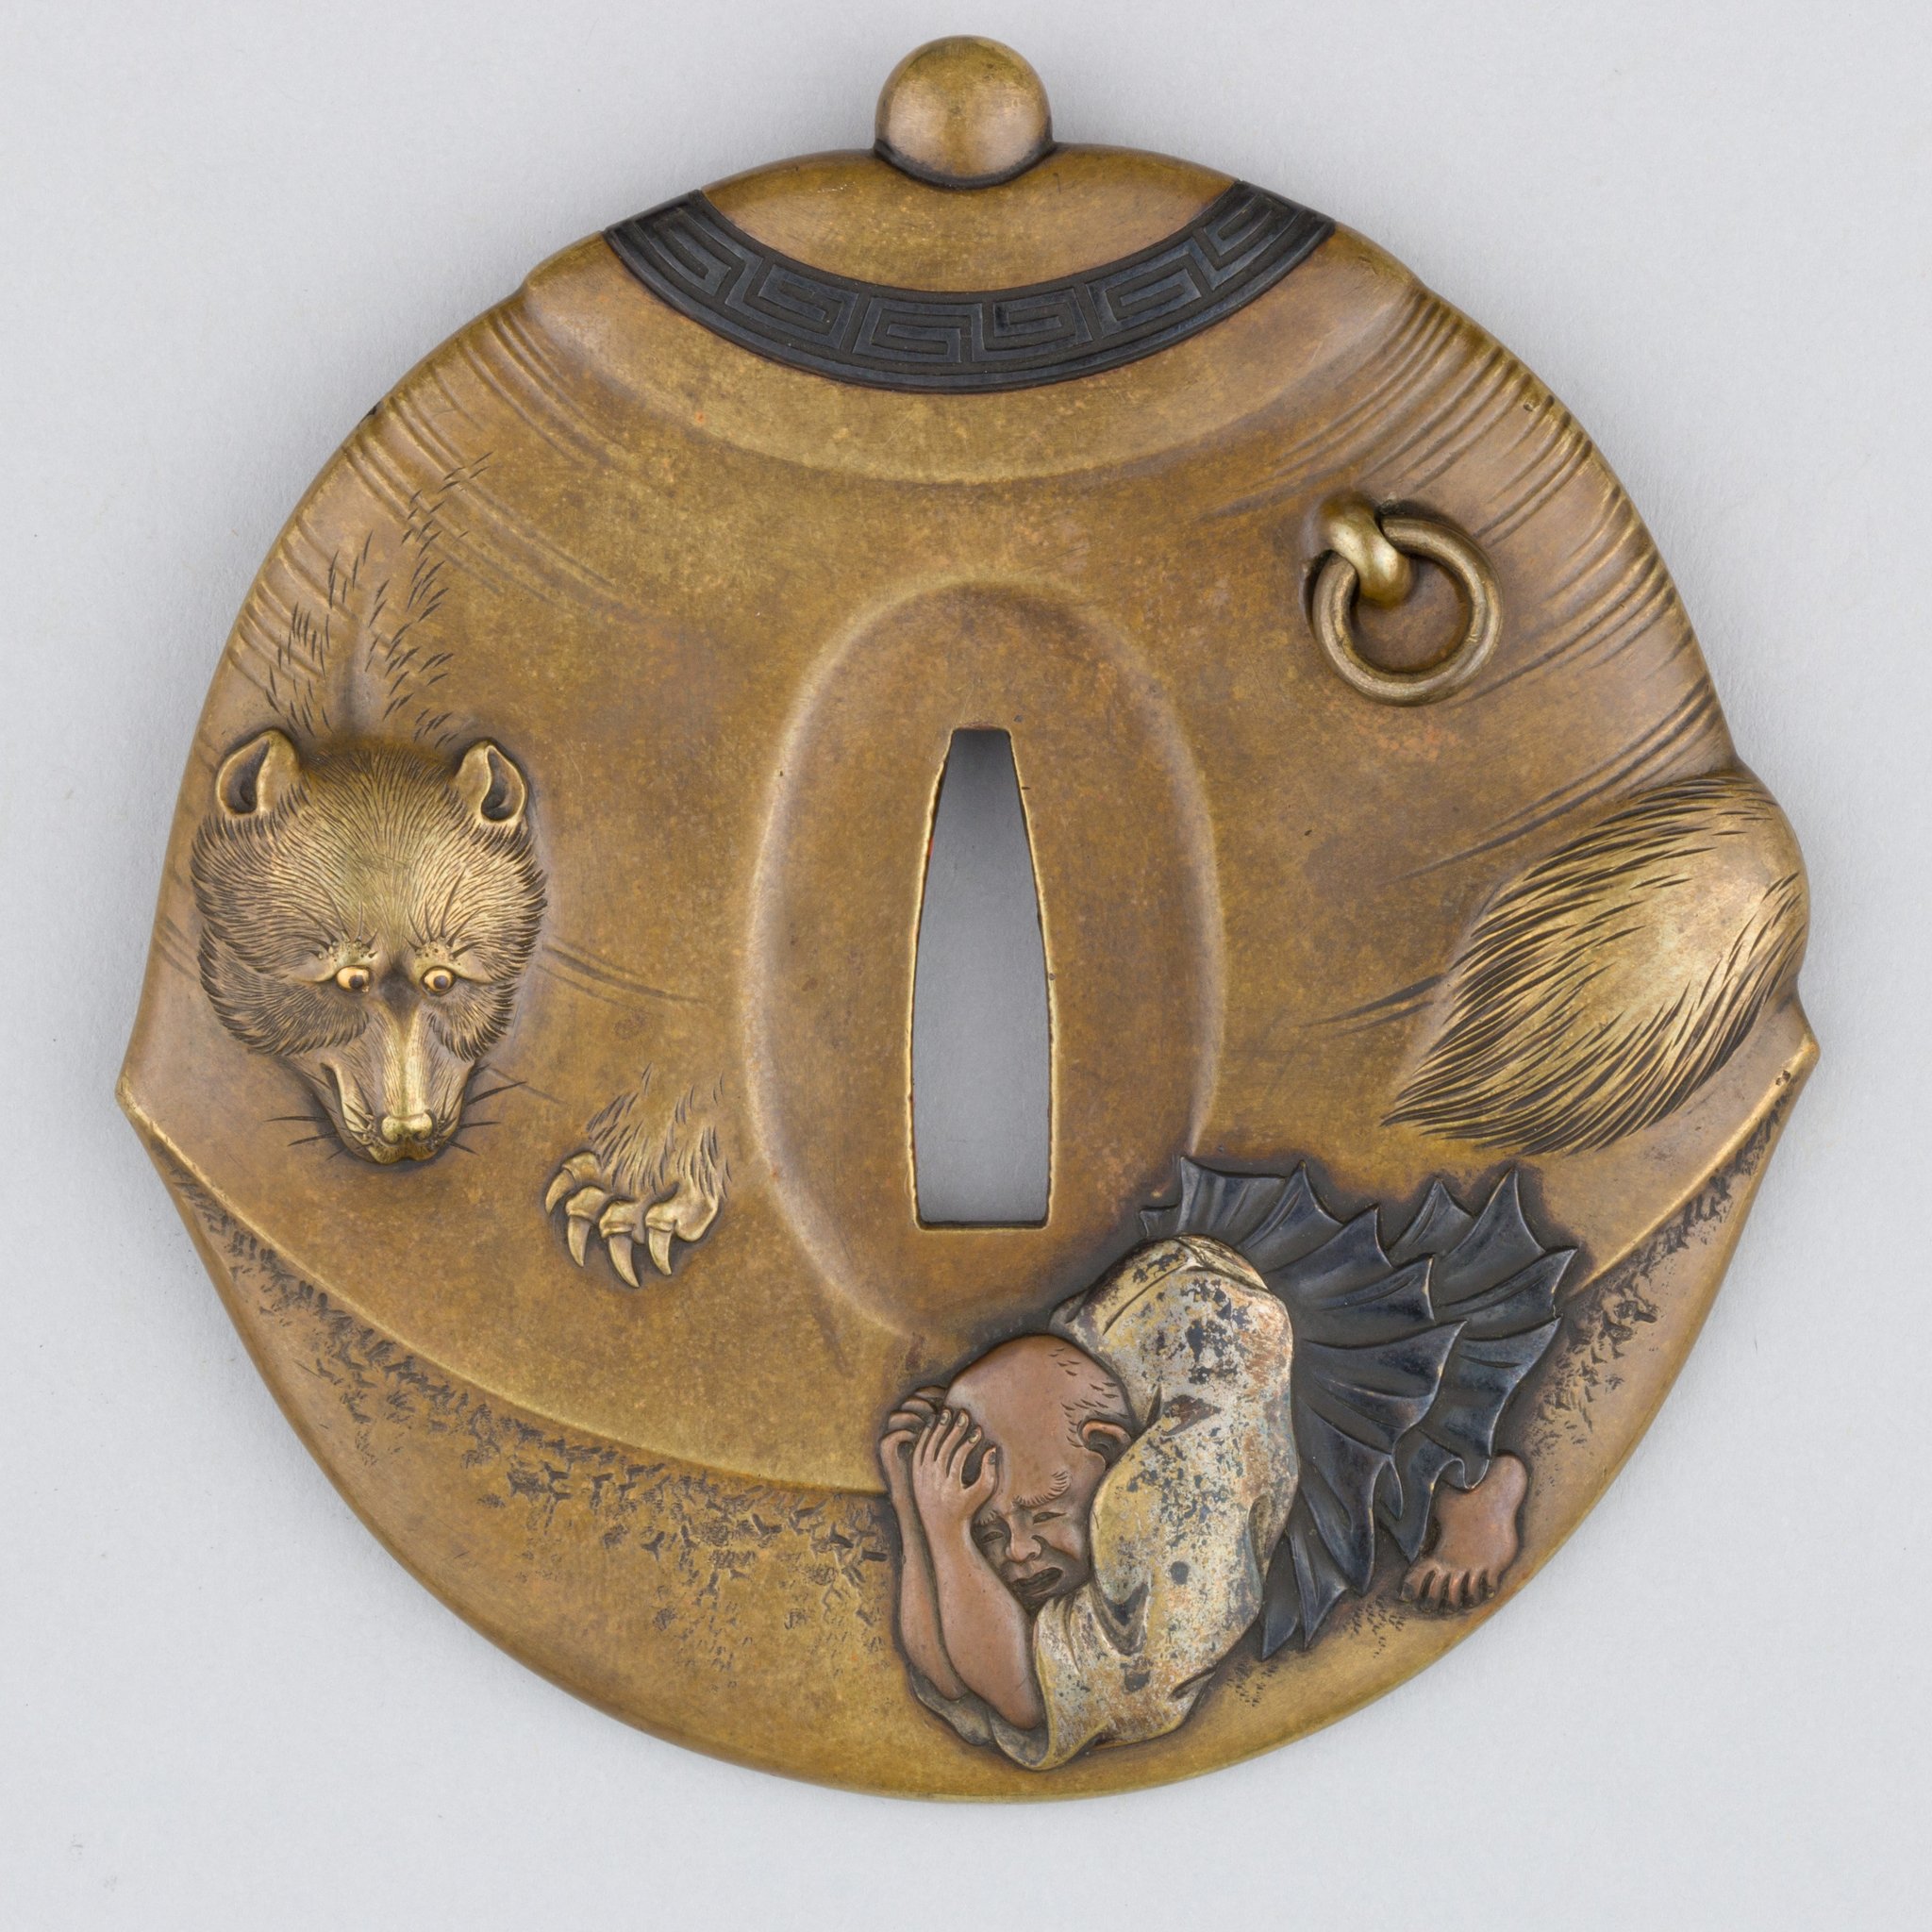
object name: sword guard tsuba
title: Sword Guard (Tsuba)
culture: japanese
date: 1701-1800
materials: brass, copper, gold alloy, silver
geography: japan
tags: animals,men